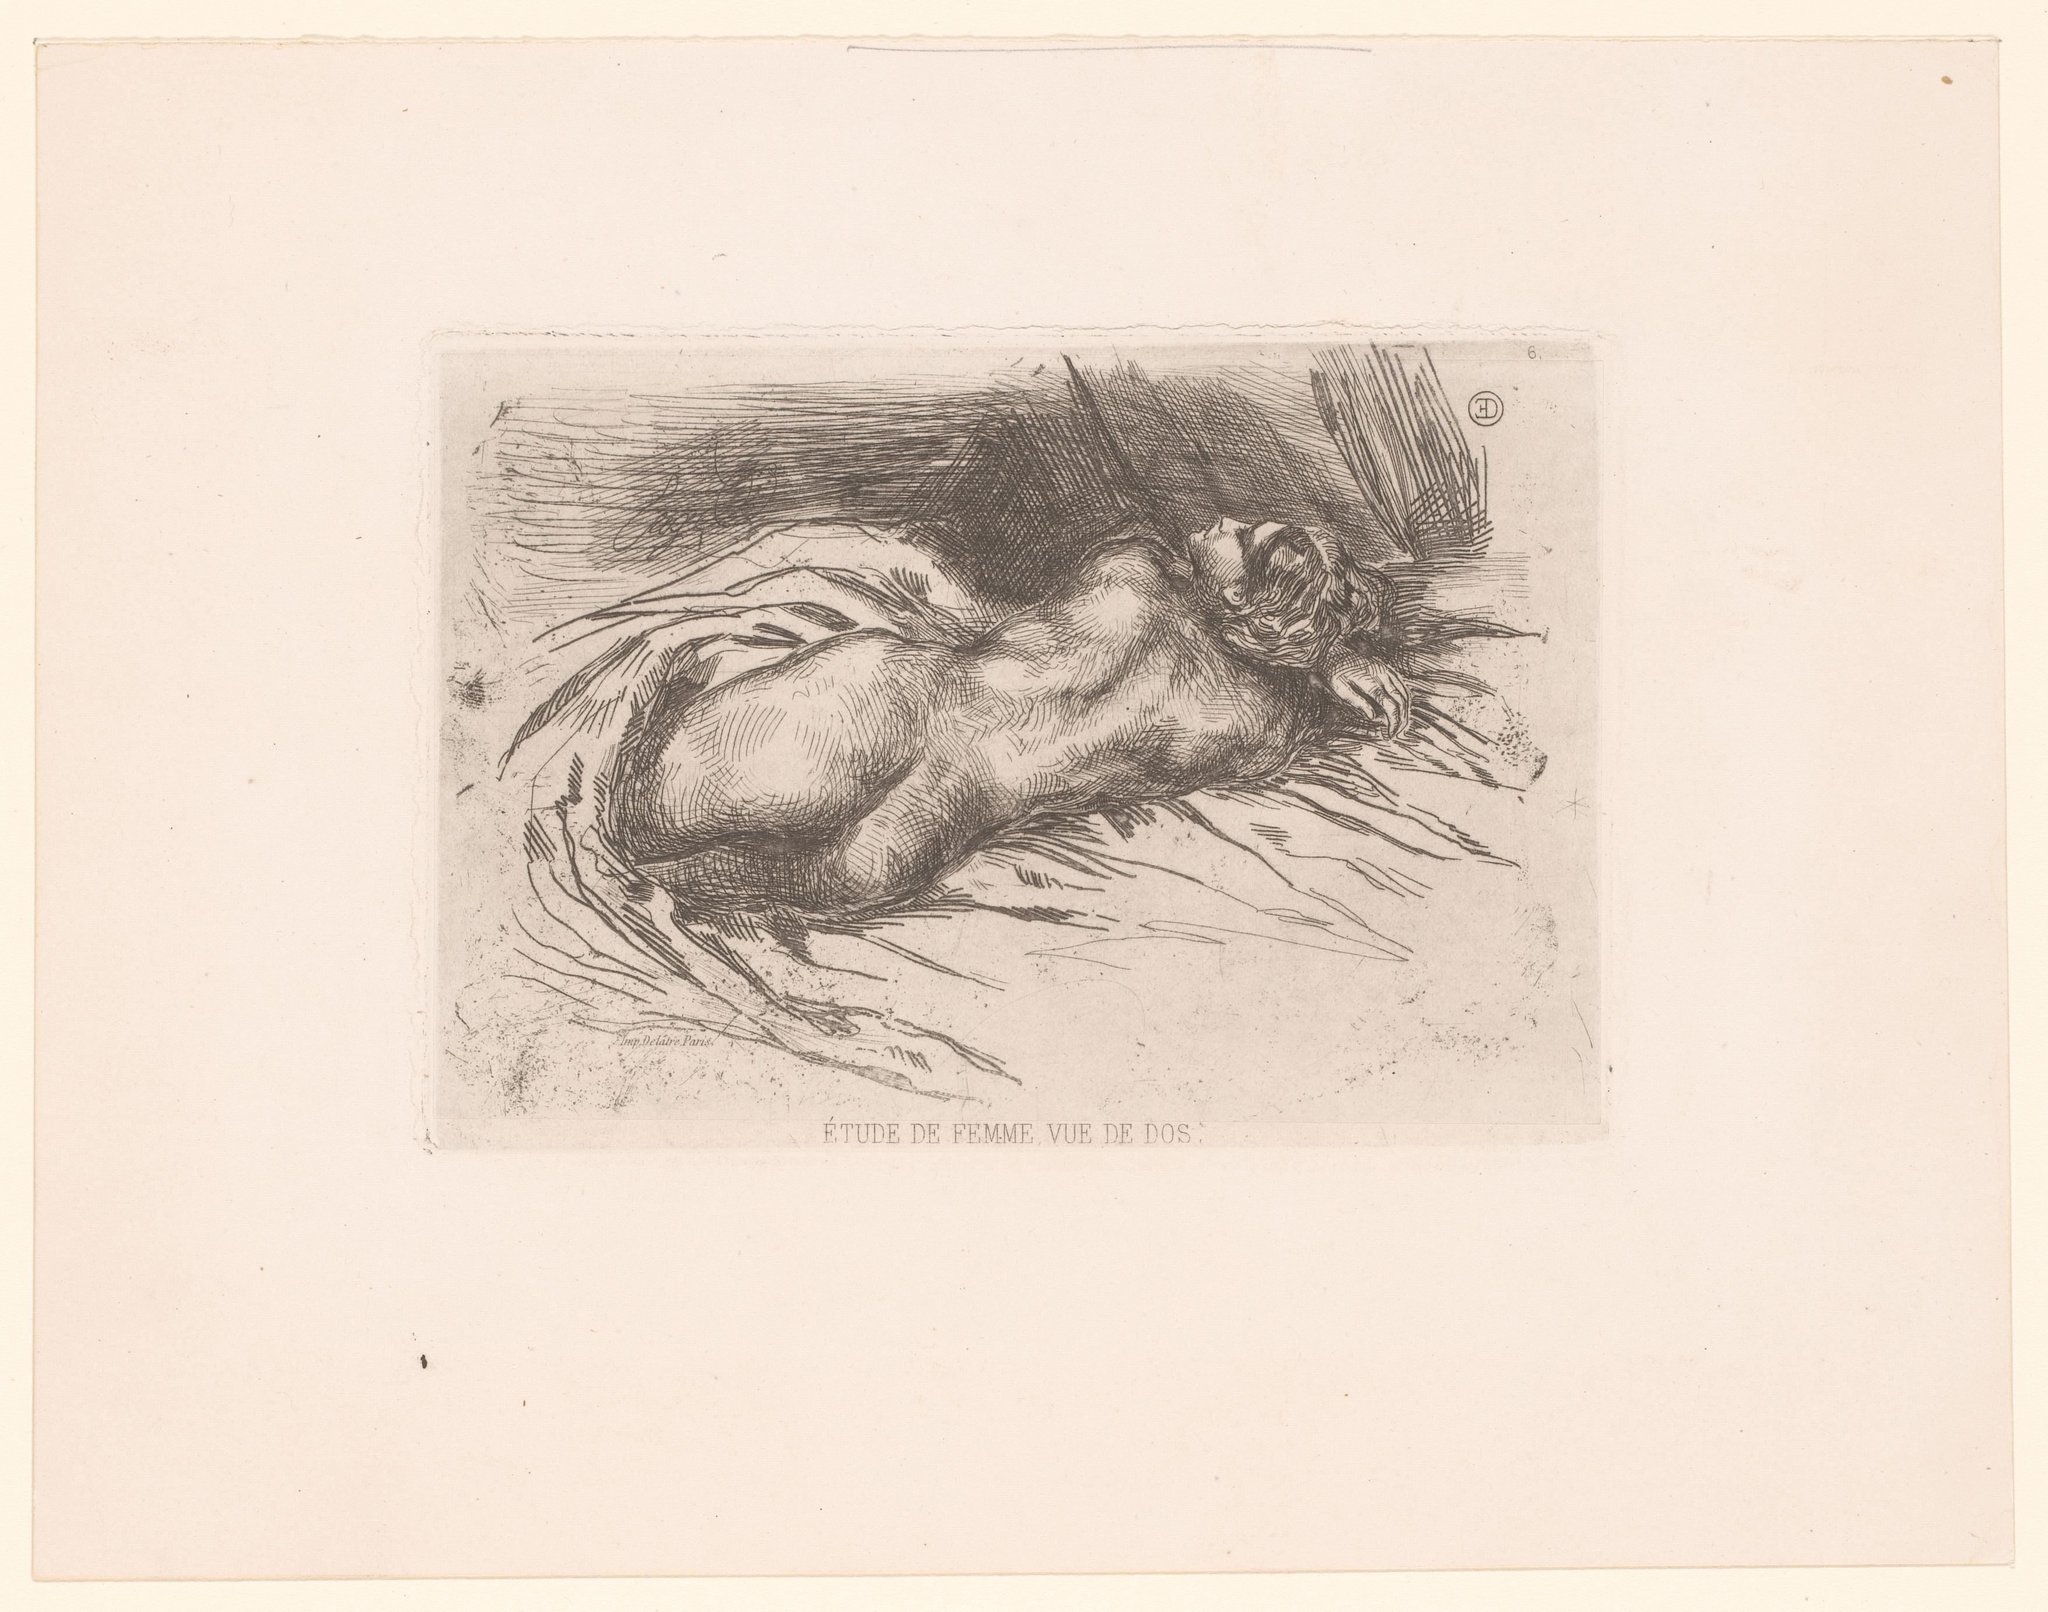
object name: print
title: Naakte vrouw op de rug gezien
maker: eugène delacroix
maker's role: draughtsman, print maker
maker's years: 1798-1863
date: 1833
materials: paper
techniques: etching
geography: paris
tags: the (nude) human figure; 'corpo humano' (ripa) - aa - female human figure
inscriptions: collector's mark: Lugt 2228